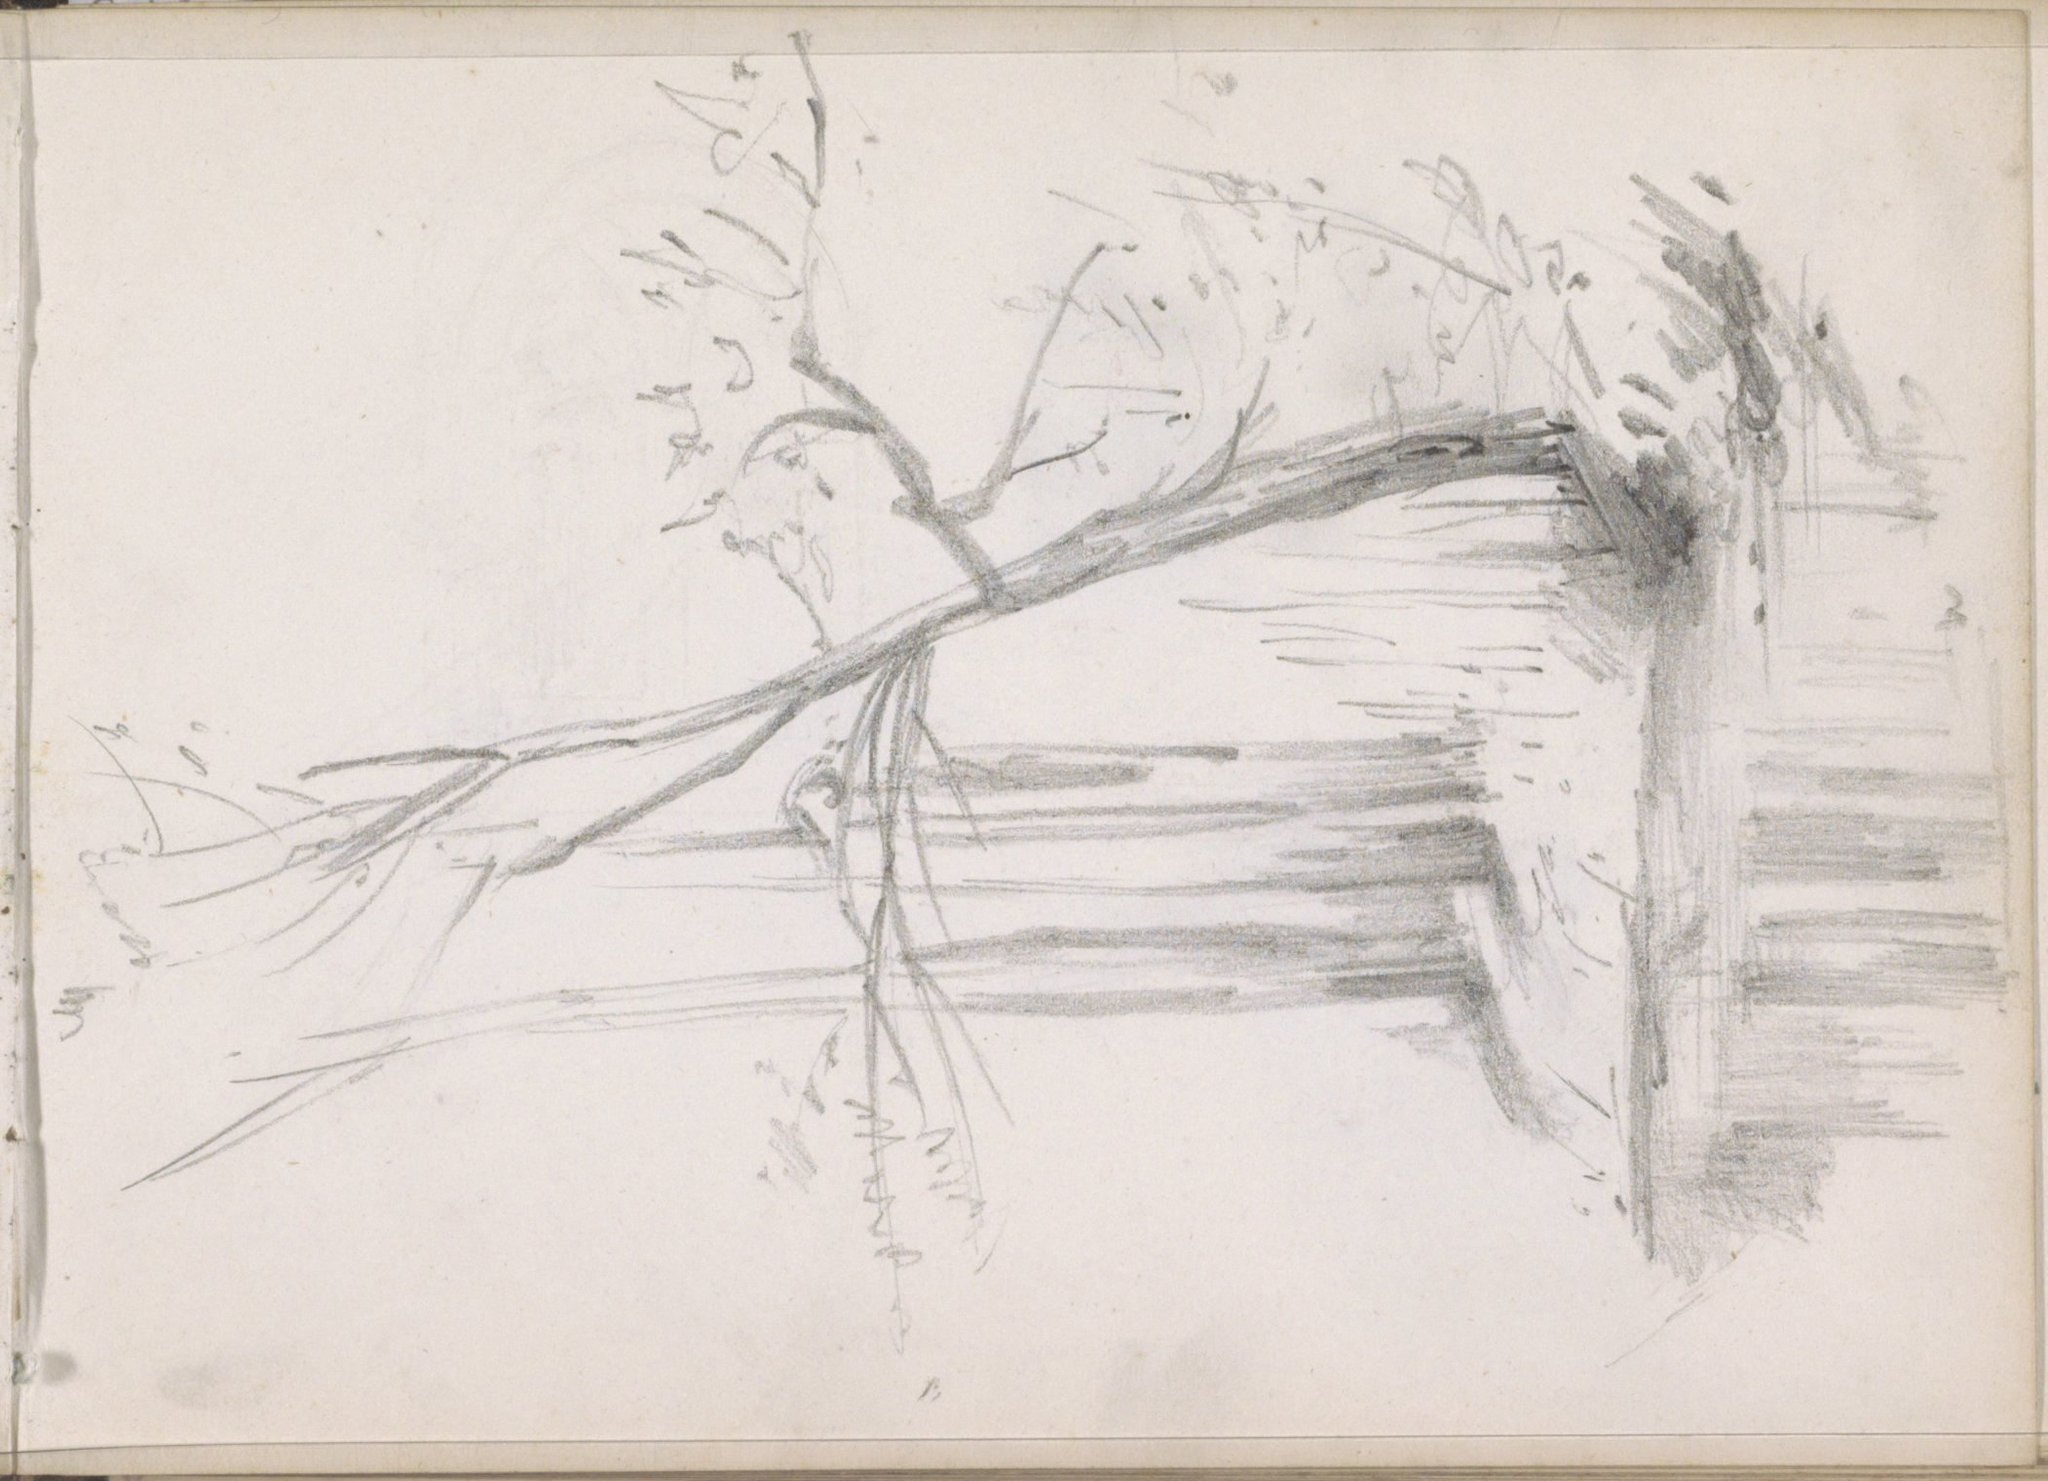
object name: sketchbook leaf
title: Bomen aan een waterkant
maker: maria vos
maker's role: draughtsman, painter, print maker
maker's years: 1824-1906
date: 1834-1906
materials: paper, pencil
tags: trees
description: Blad 7 recto uit een schetsboek met 30 bladen.